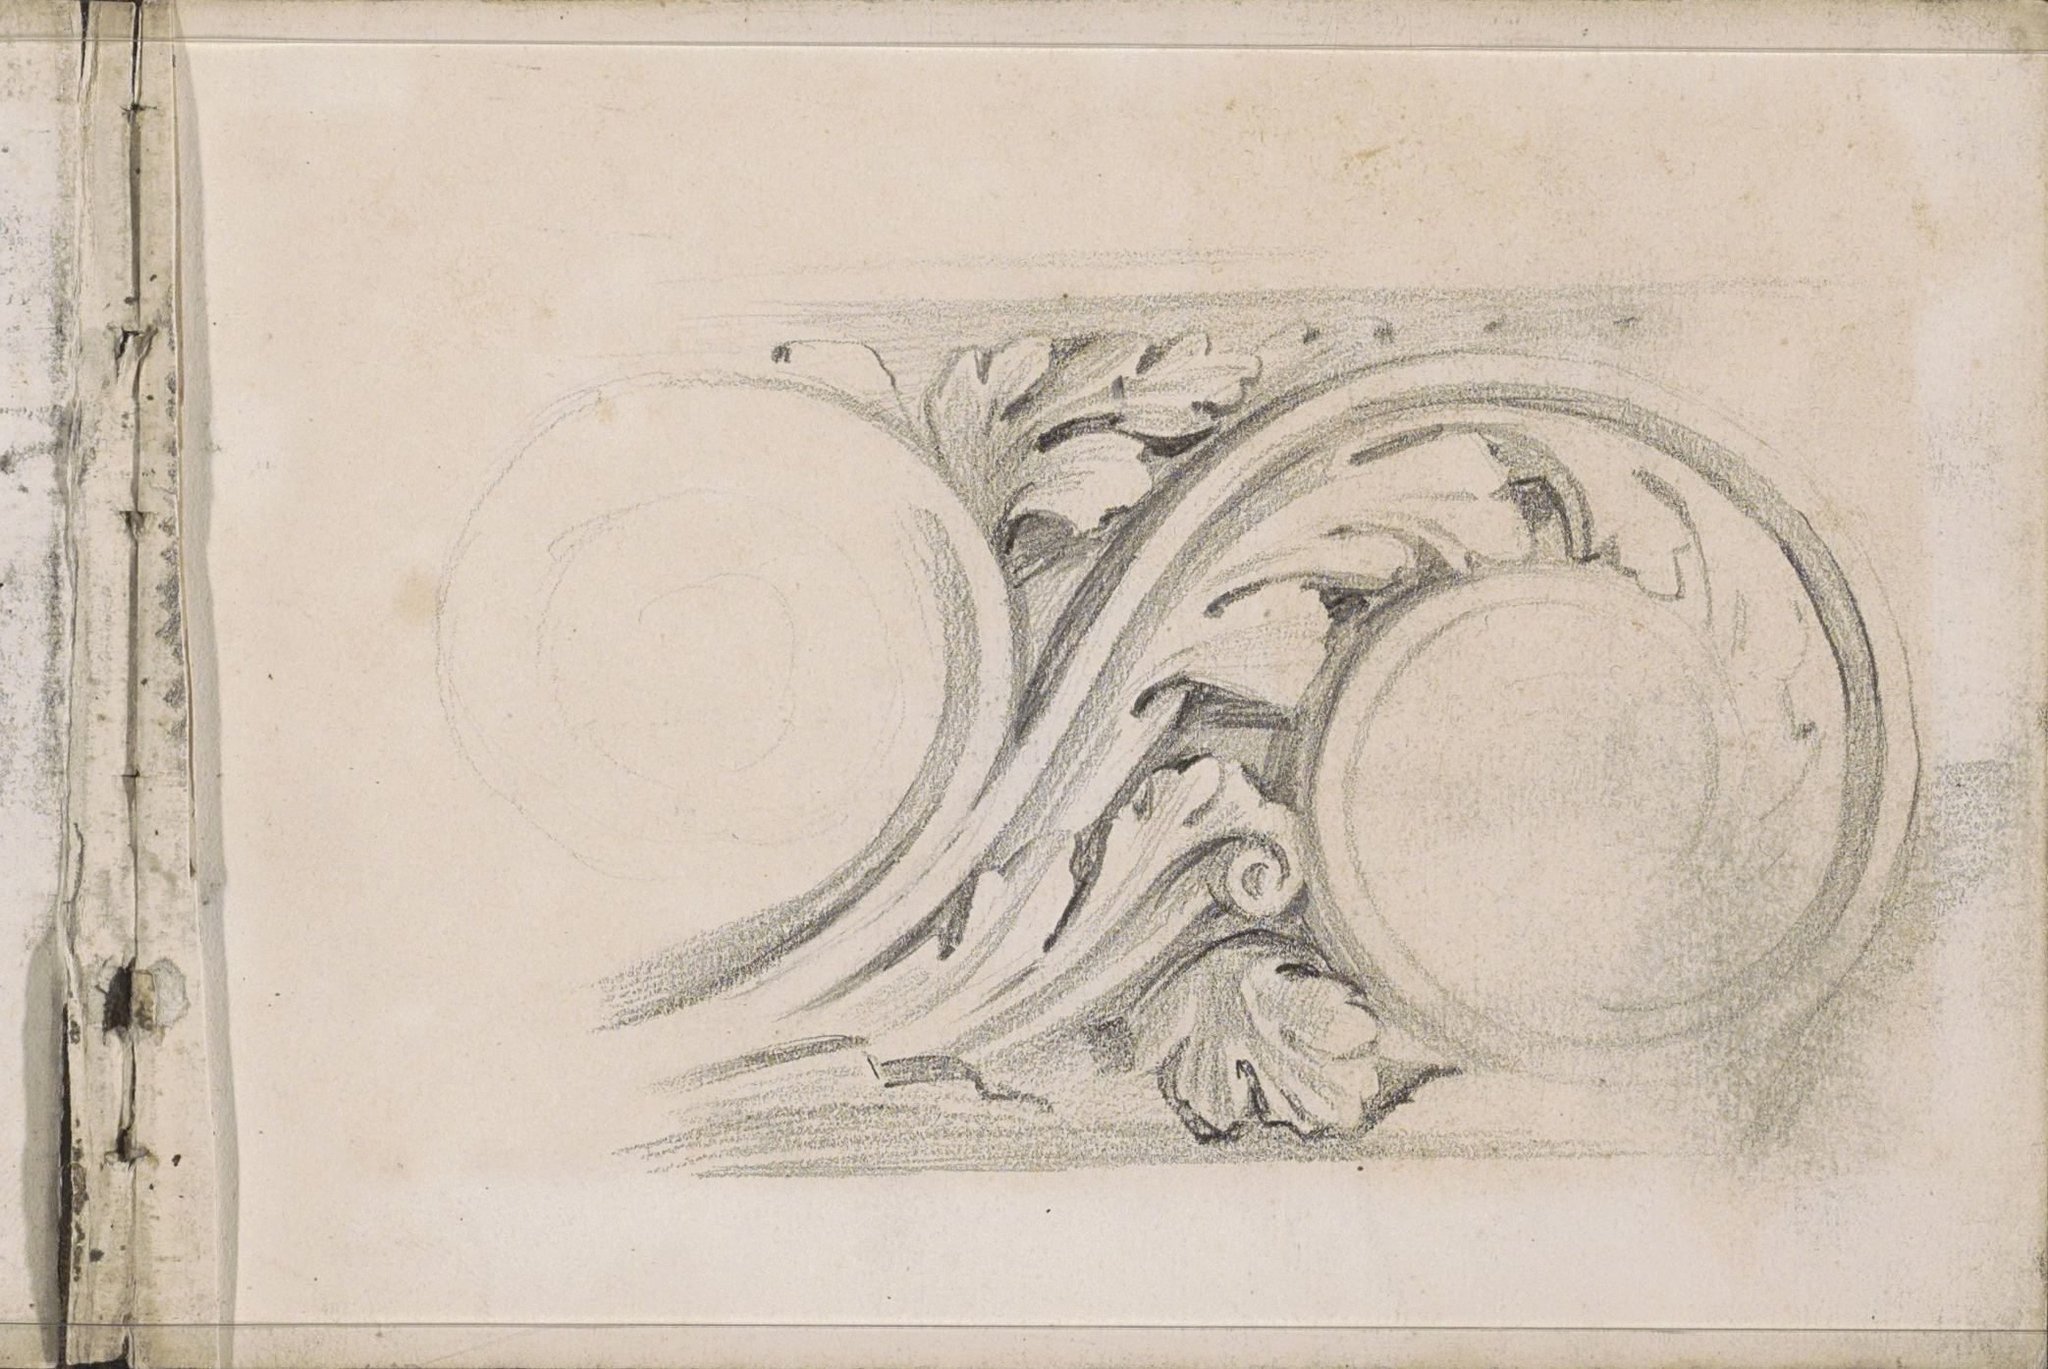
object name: sketchbook leaf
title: Ornament met acanthusbladeren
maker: jac van looij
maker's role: draughtsman, painter, print maker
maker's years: 1855-1930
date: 1877-1880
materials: paper, pencil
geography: amsterdam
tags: acanthus ~ ornament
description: Blad 1 recto uit een schetsboek met 27 bladen.